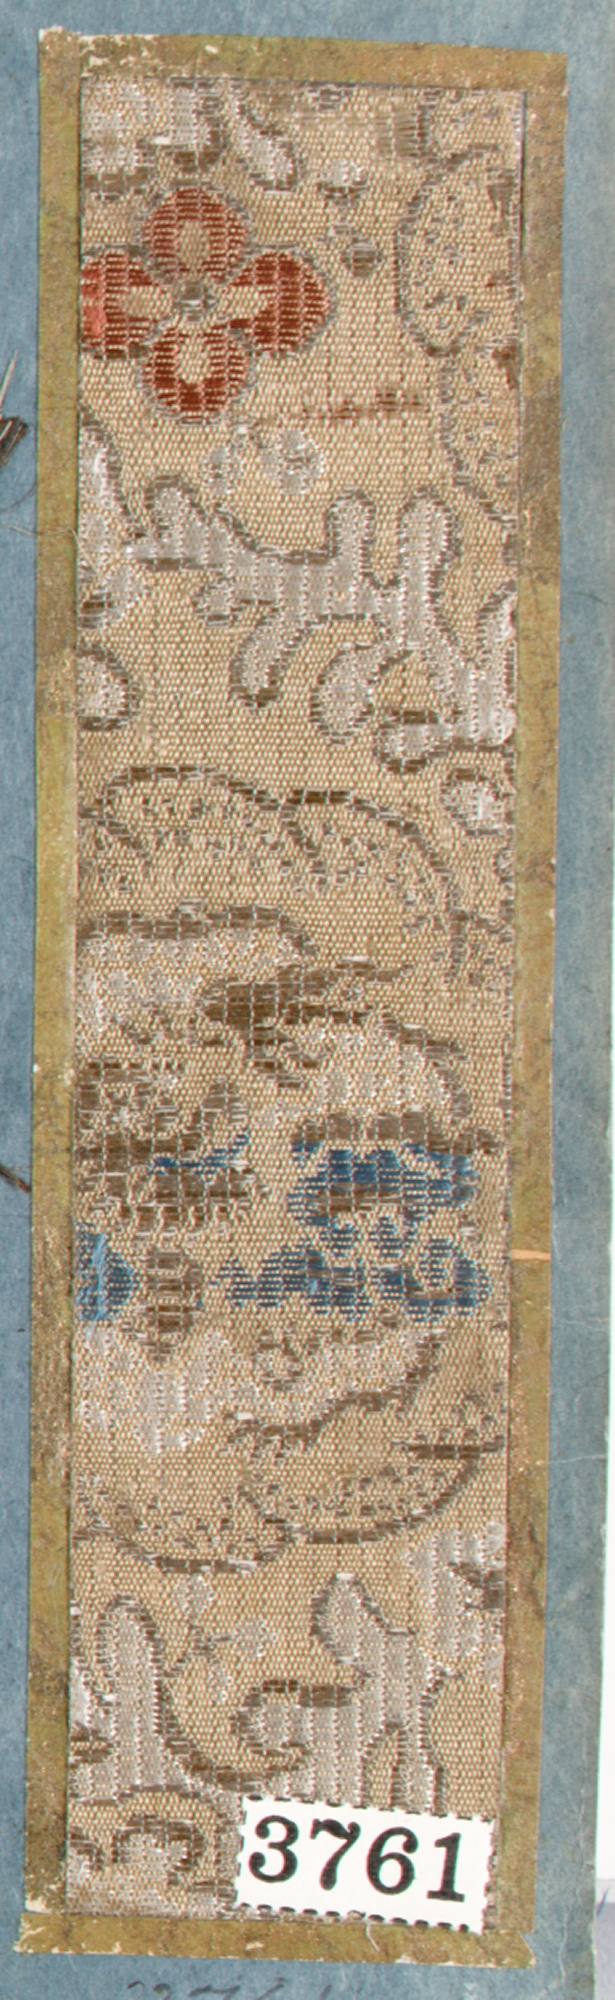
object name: sample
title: Textile Sample from Sample Book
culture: japanese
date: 1801-1900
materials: silk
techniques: tapestry